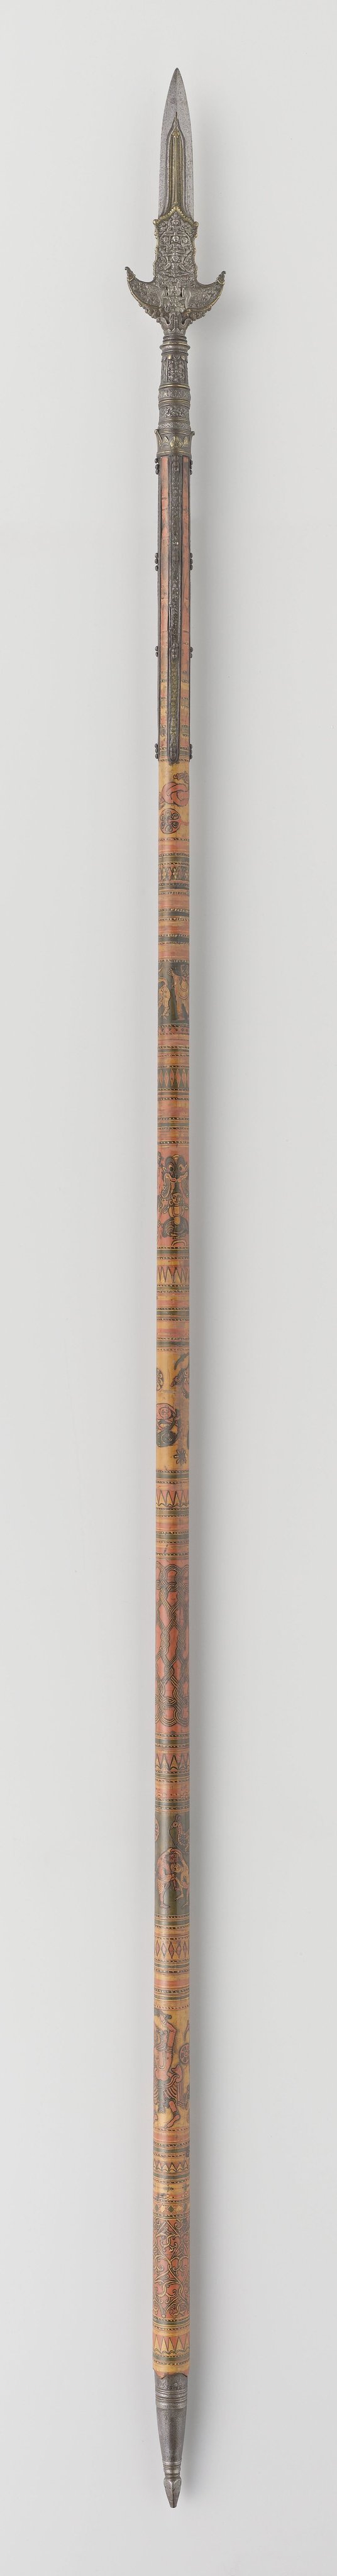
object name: partisan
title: Lans van het wapenrek van Gouverneur-Generaal J.C. baron Baud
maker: Anonymous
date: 1700-1800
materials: iron, paint, silver, wood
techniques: casting, cutting, forging, painted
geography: india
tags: the hague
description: Ronde houten schacht beschilderd in zwart, rood, geel en groen met voorstellingen van Boddhisattva's, menselijke figuren en geometrische motieven. Onderzijde schacht heeft ijzeren kegelvorm met geschulpte rand en toelopend in stompe vierkante punt. Brede kling uitlopend in scherpe punt, met vier lippen. Kling is rijk versierd in reliëf met boddhisattva's en bloem- en bladmotieven. Centraal in kling verticale inkepingen.